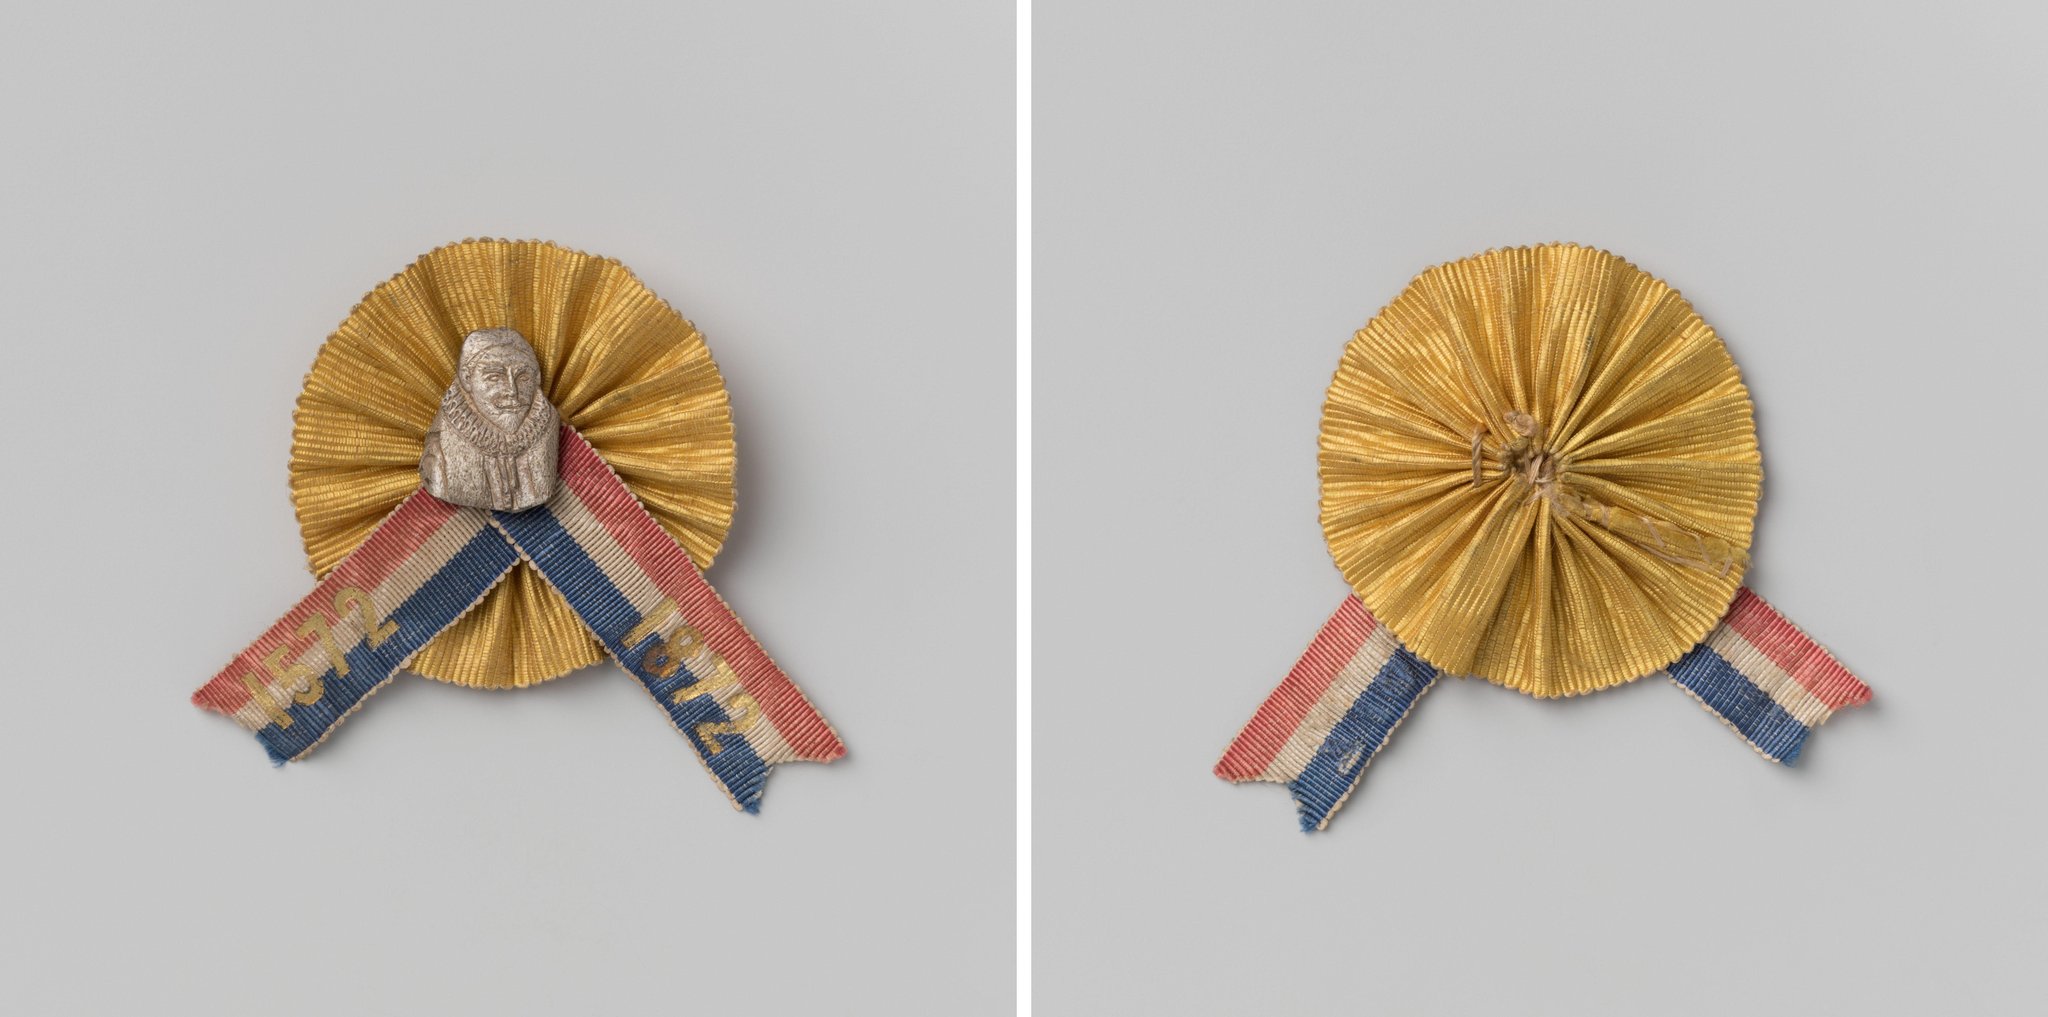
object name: insignia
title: Derde eeuwfeest van de inname van Den Briel, ter ere van Willem I, prins van Oranje-Nassau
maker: Anonymous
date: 1873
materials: silver, textile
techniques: striking, weave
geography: netherlands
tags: delft, william i (prince of orange), brielle